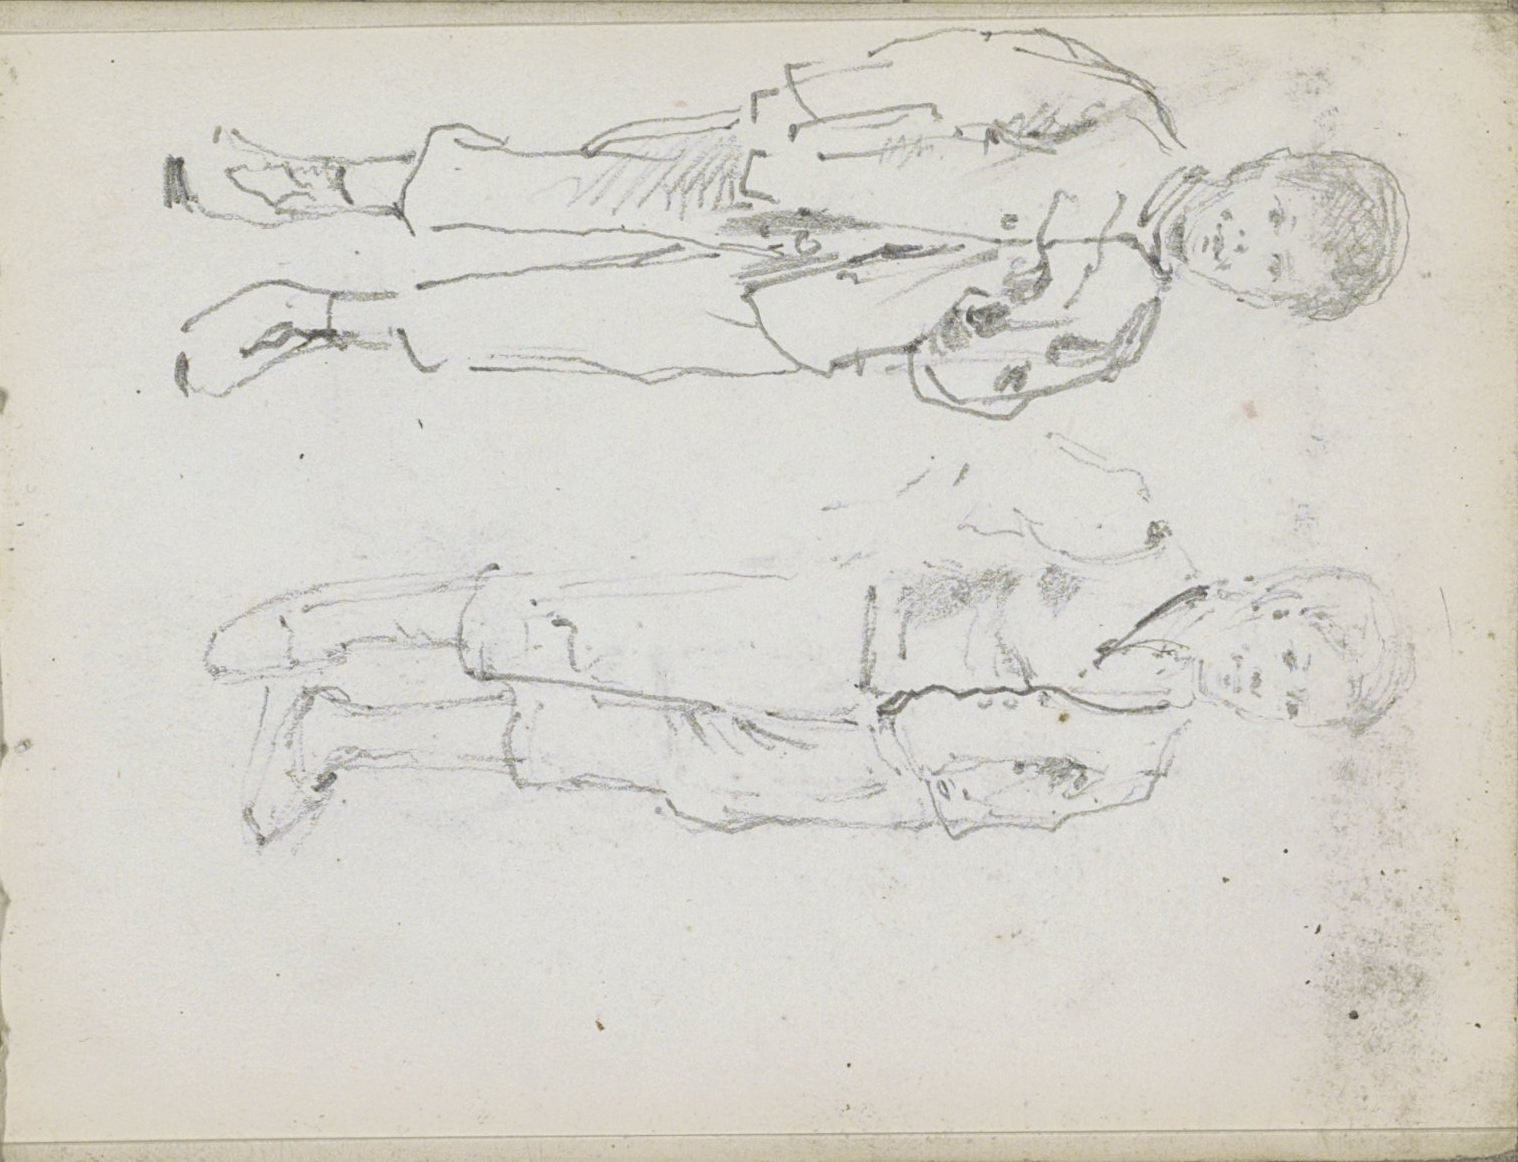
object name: sketchbook leaf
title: Twee Antwerpse jongens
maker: george clausen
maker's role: draughtsman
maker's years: 1852-1912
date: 1874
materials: paper, pencil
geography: antwerp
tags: standing figure, boy (child between toddler and youth), antwerp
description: Blad 37 recto uit een schetsboek met 37 bladen.